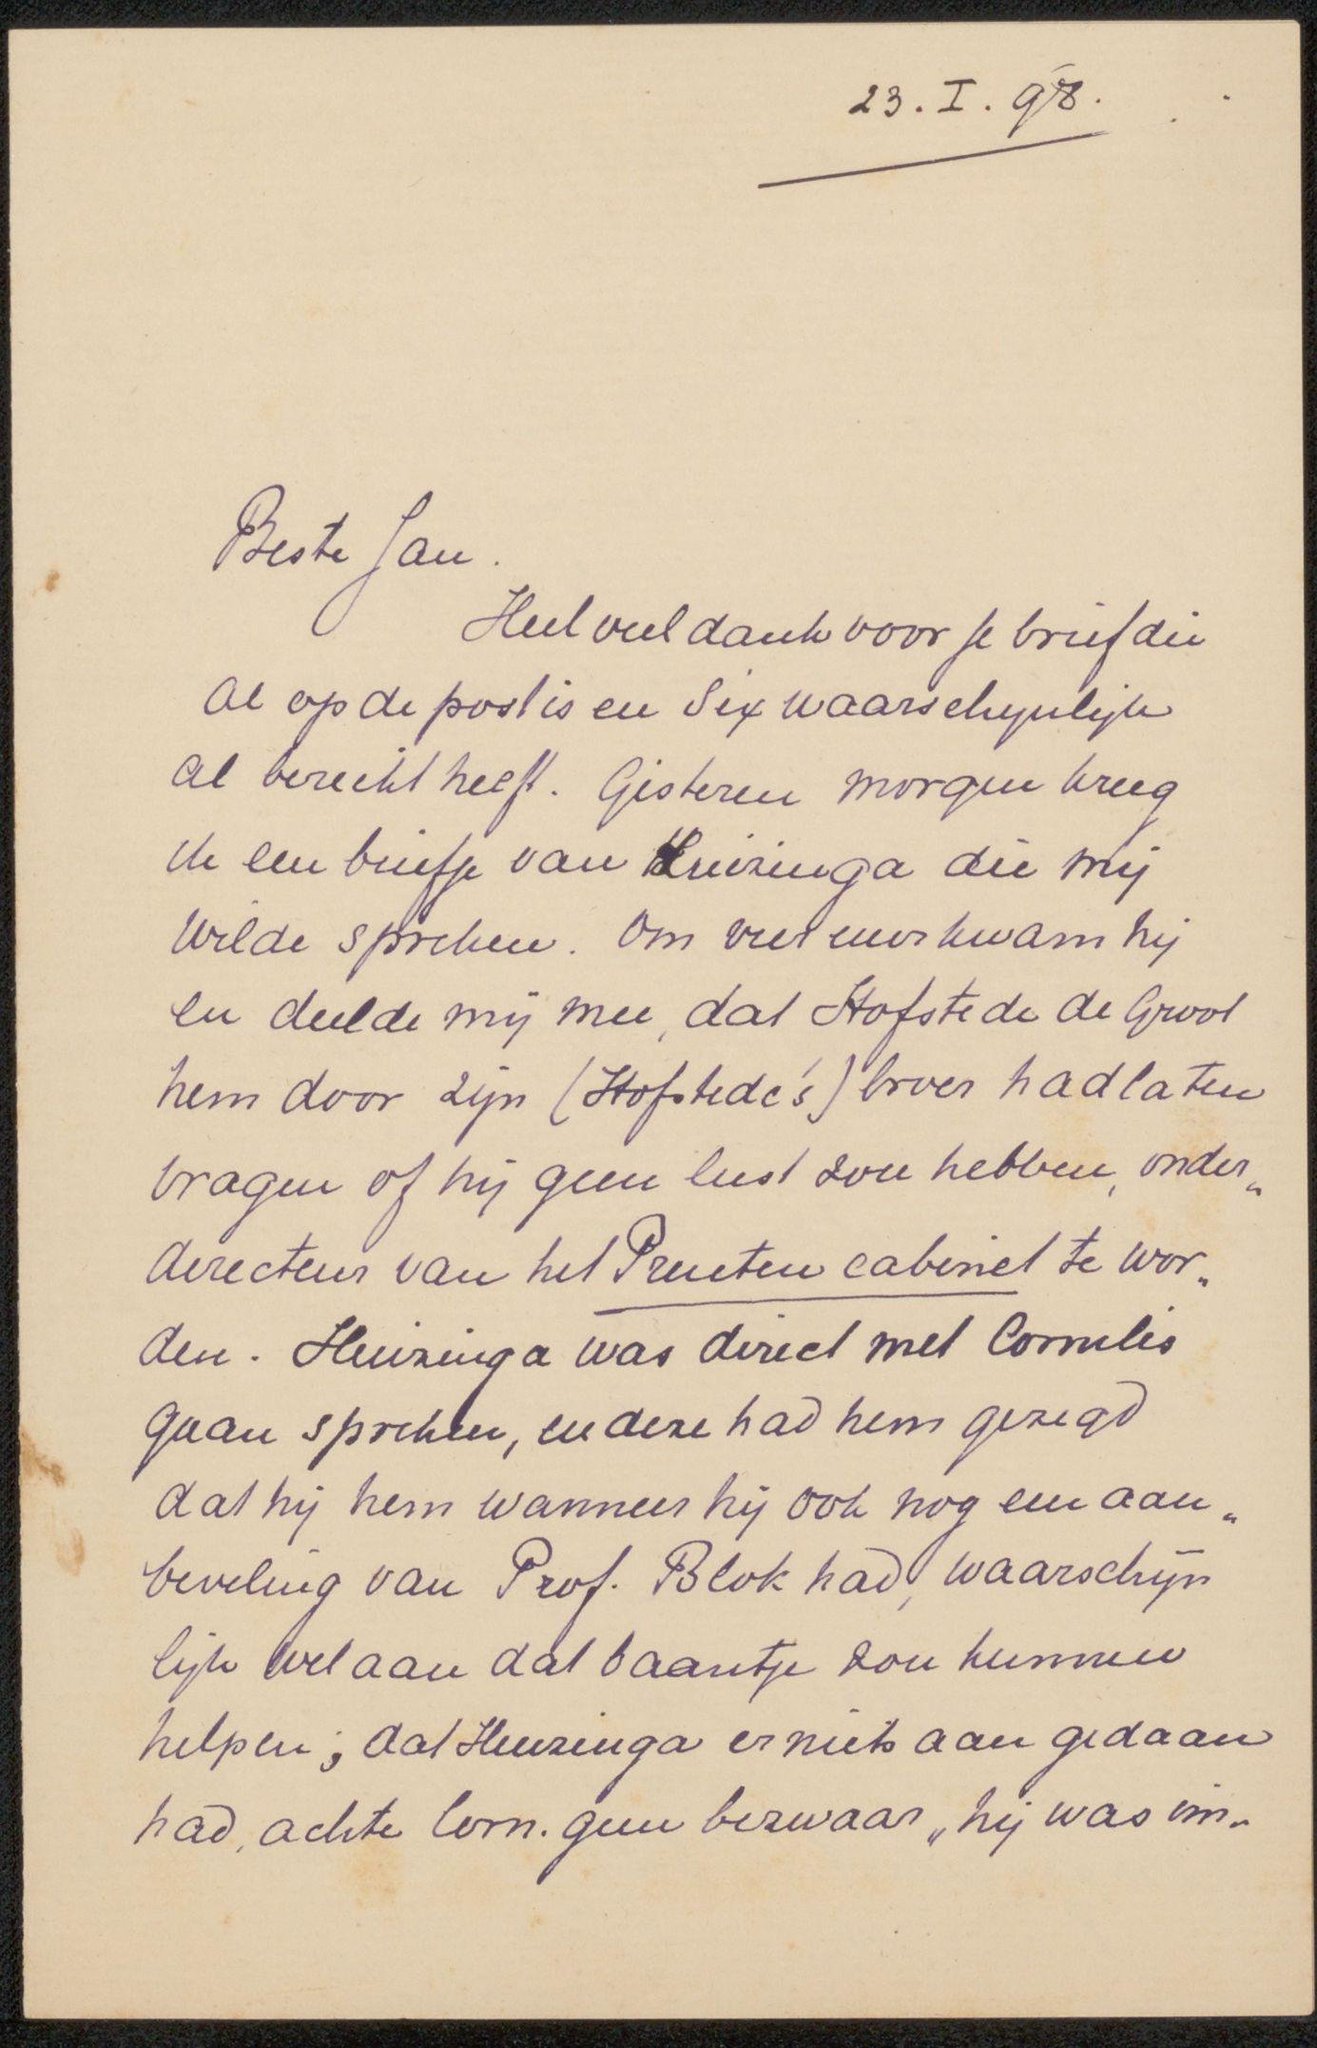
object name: letter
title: Brief aan Jan Veth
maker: andré jolles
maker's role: journalist, kunsthistoricus, letterkundige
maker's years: 1874-1946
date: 1898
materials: ink, paper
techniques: pen, writing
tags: dordrecht, painter, print maker, draughtsman, designer, jan veth, den helder, leiden, johan huizinga, jonkheer jan six, cornelis hofstede de groot, rijksmuseum amsterdam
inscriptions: collector's mark: ‘RPK’